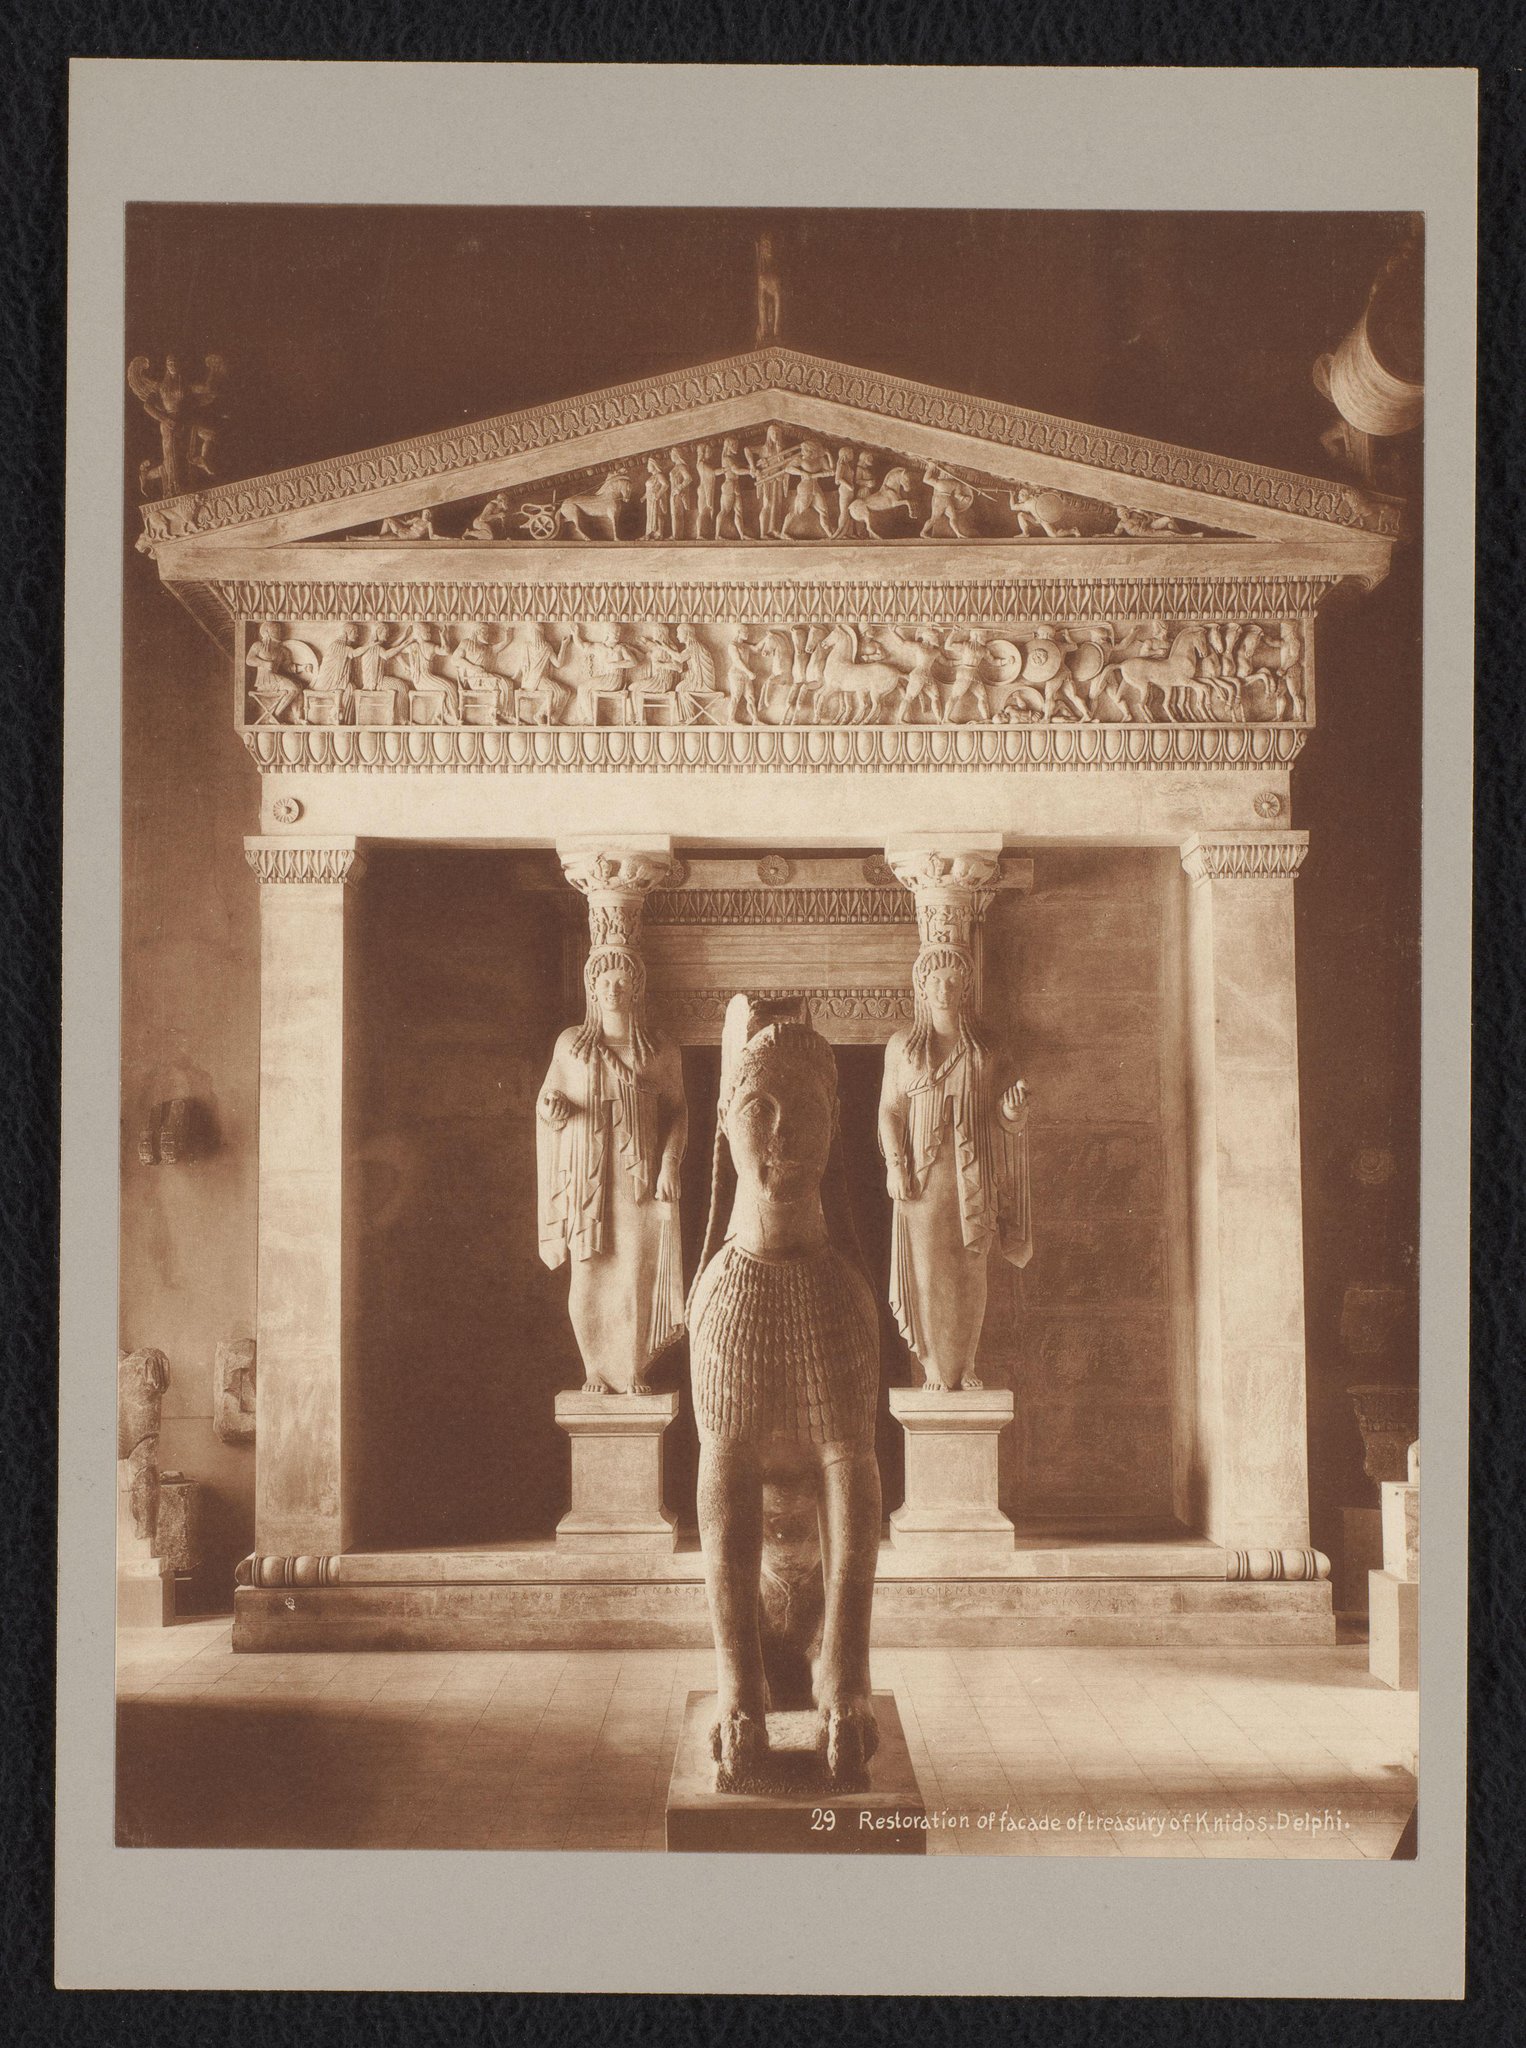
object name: photograph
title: Voorgevel van schatkamer van Knidos, Delphi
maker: Anonymous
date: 1895-1915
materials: cardboard, paper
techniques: photograph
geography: delphi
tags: delphi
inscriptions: number: ‘20.’